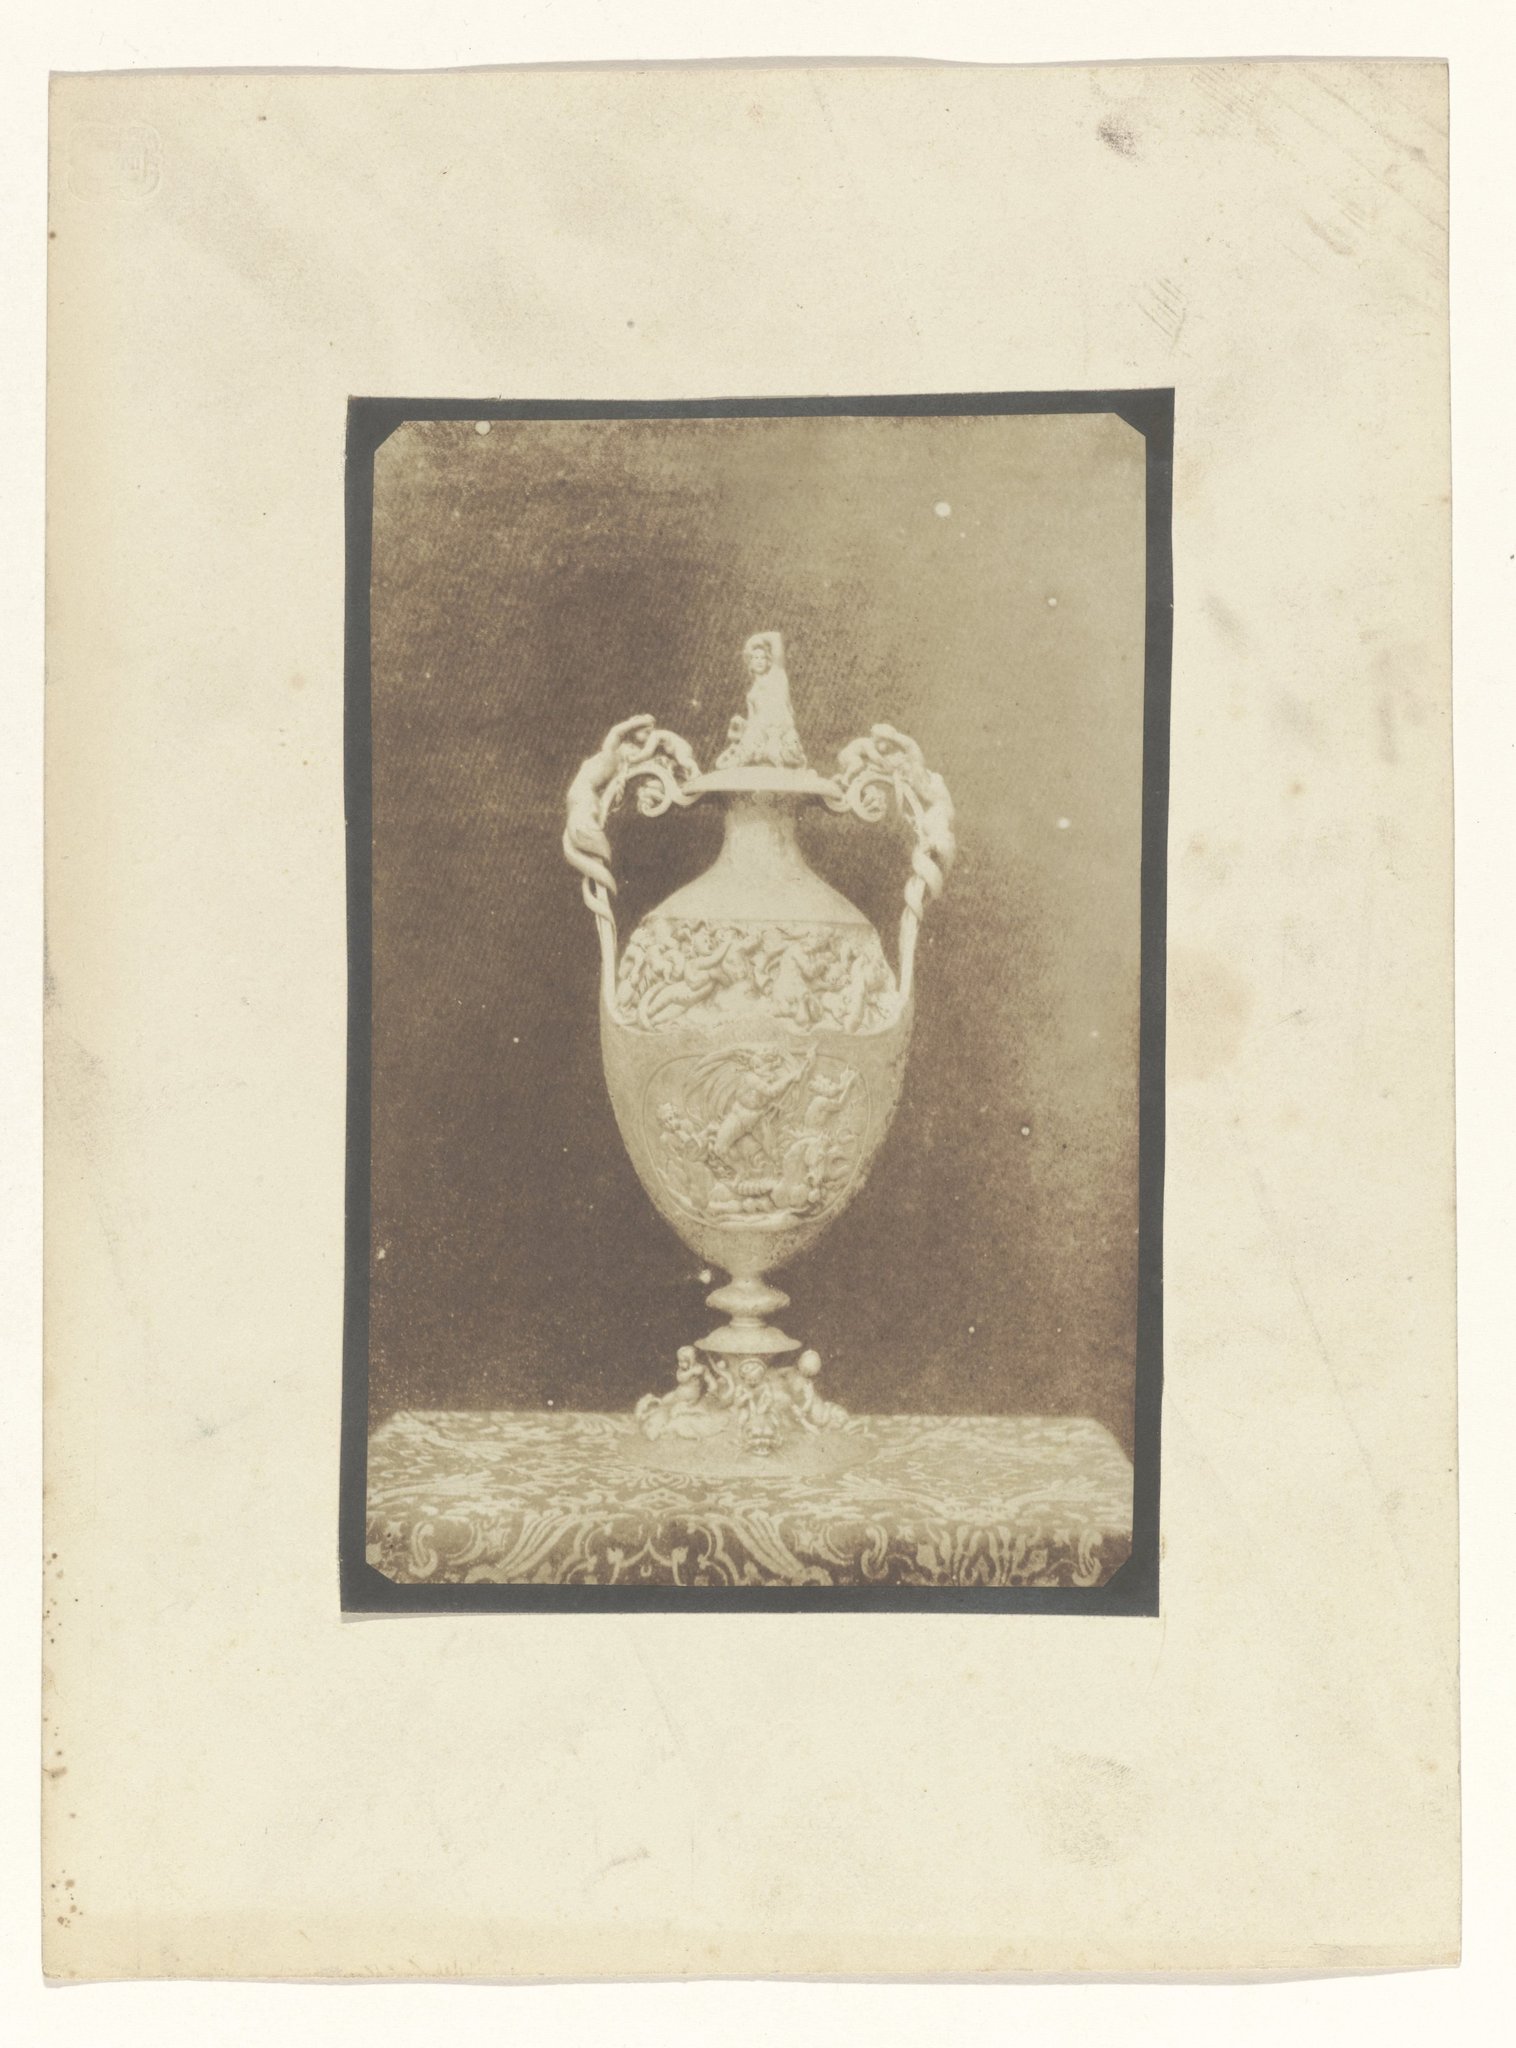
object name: photograph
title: Zilveren vaas van Antoine Vechte, 'Neptune et Galathee'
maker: hippolyte bayard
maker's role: fotograaf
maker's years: 1801-1887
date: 1847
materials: cardboard, paper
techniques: salted paper print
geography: france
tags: containers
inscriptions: check stamp: ‘.ath’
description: Zilveren vaas van Antoine Vechte 'Neptune et Galathee' die zich nu in het Rijksmuseum bevindt.